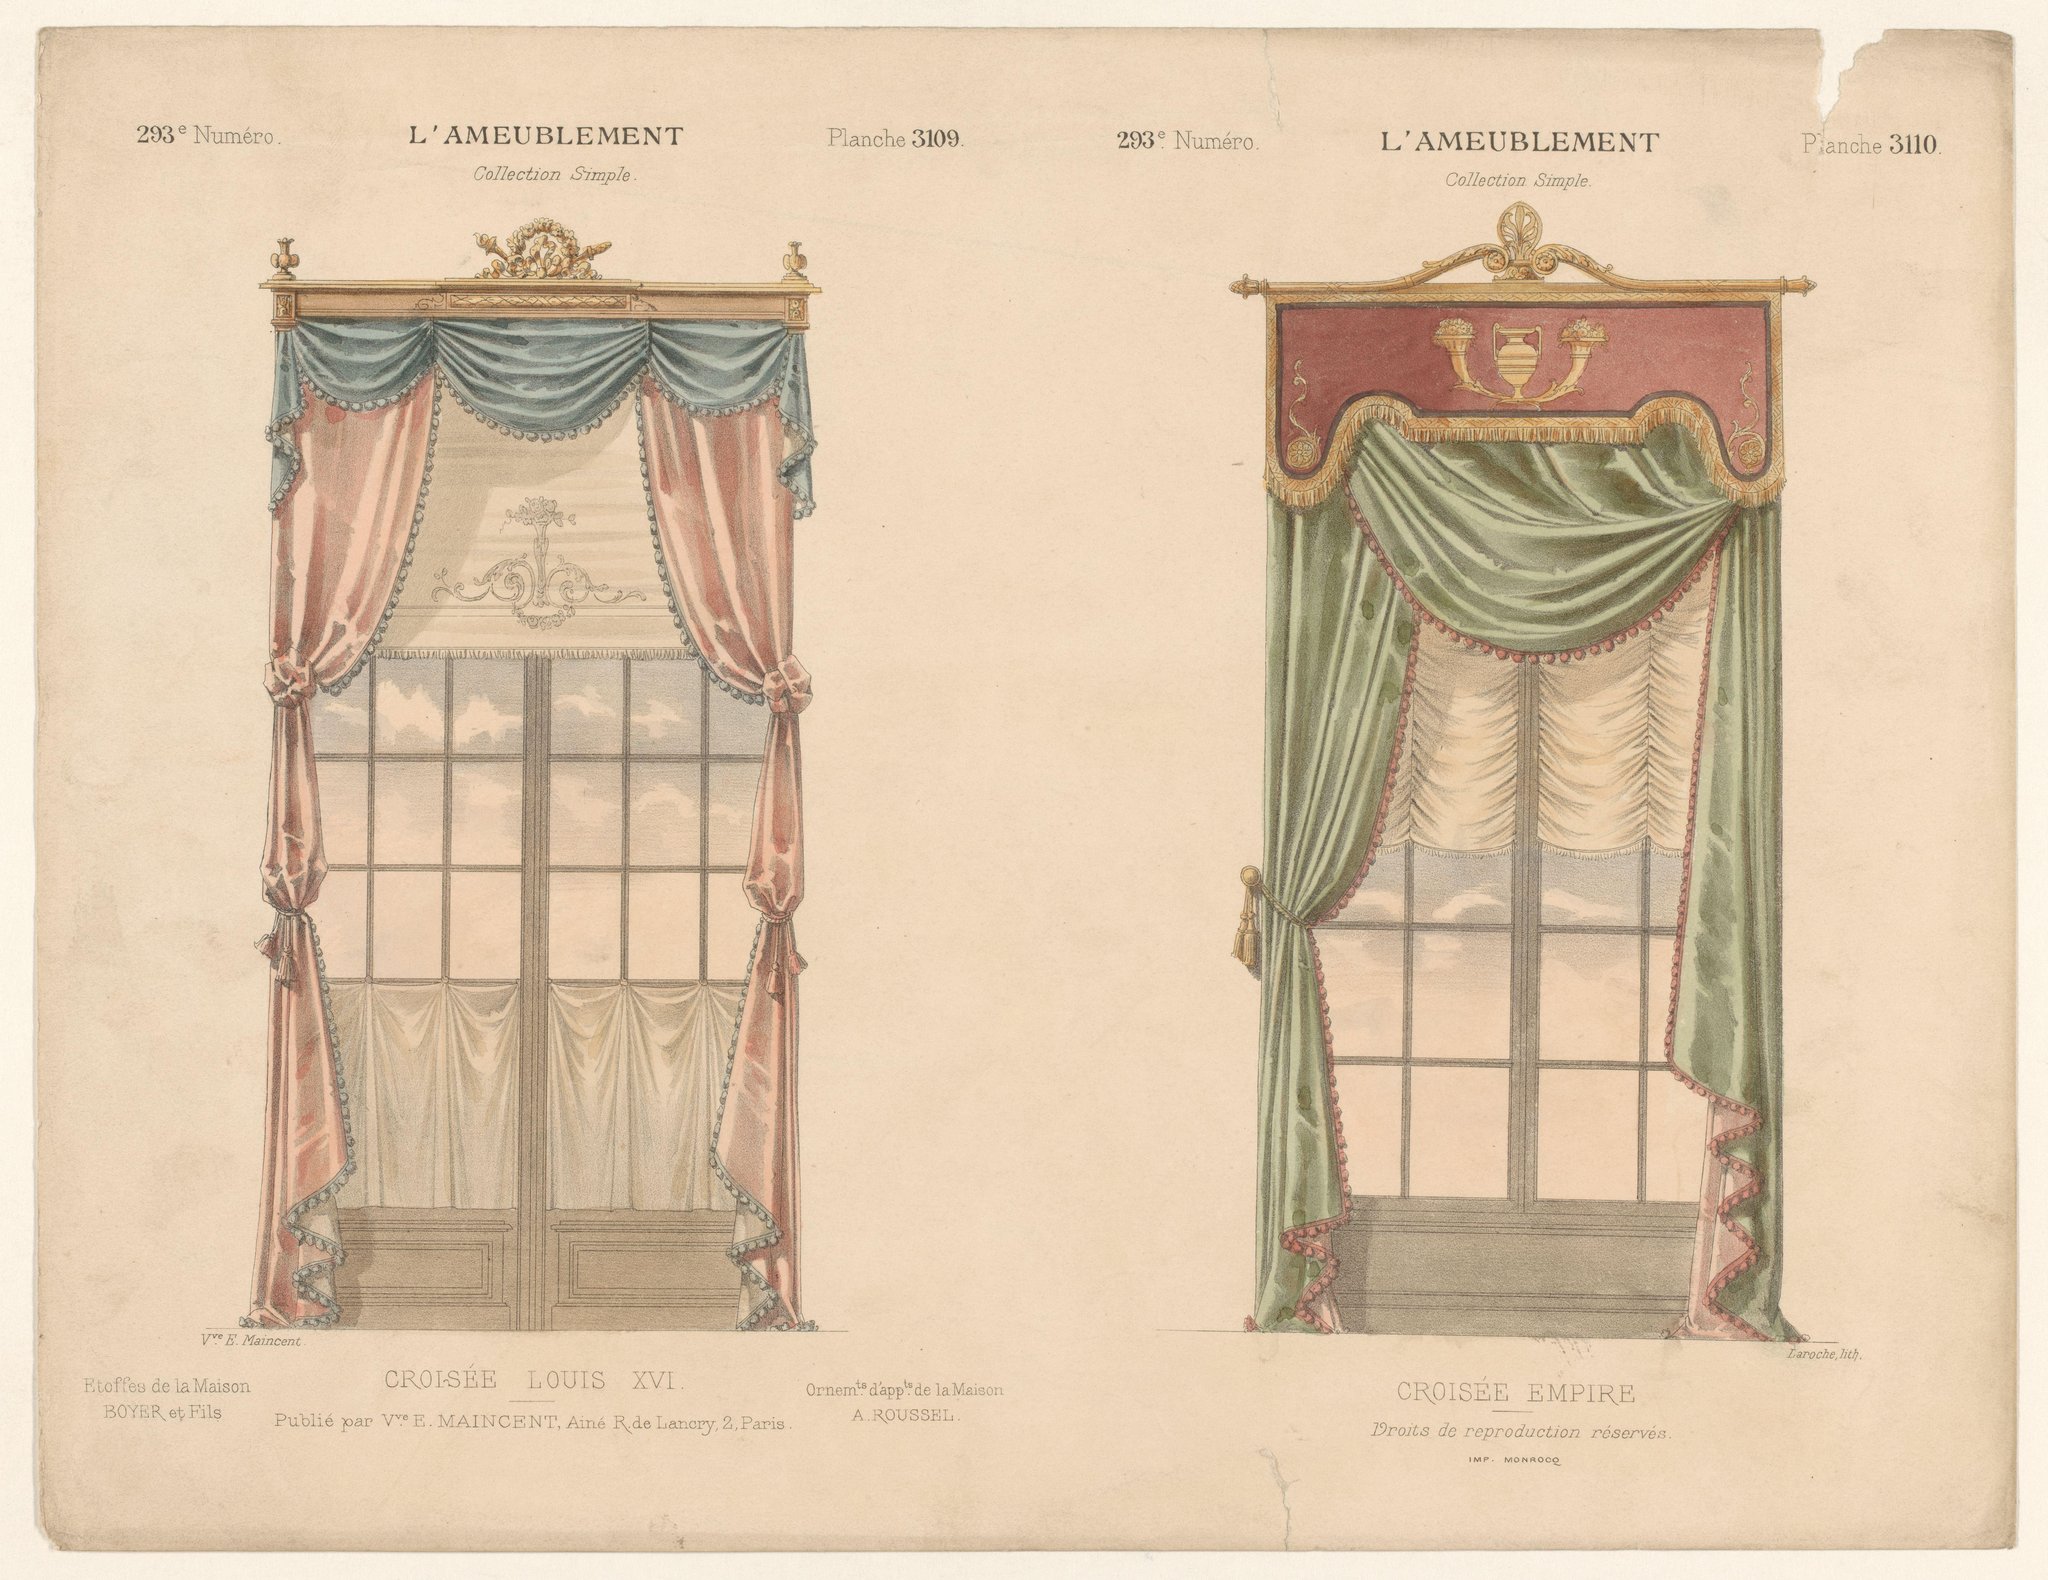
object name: print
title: L'ameublement / Collection simple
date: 1895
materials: paper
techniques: hand coloring, lithograph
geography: paris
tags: window, hangings and drapery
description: Twee vensters met gedrapeerde gordijnen, in de Lodewijk XVI-stijl en de empirestijl. . Prent uit 293e Livraison.